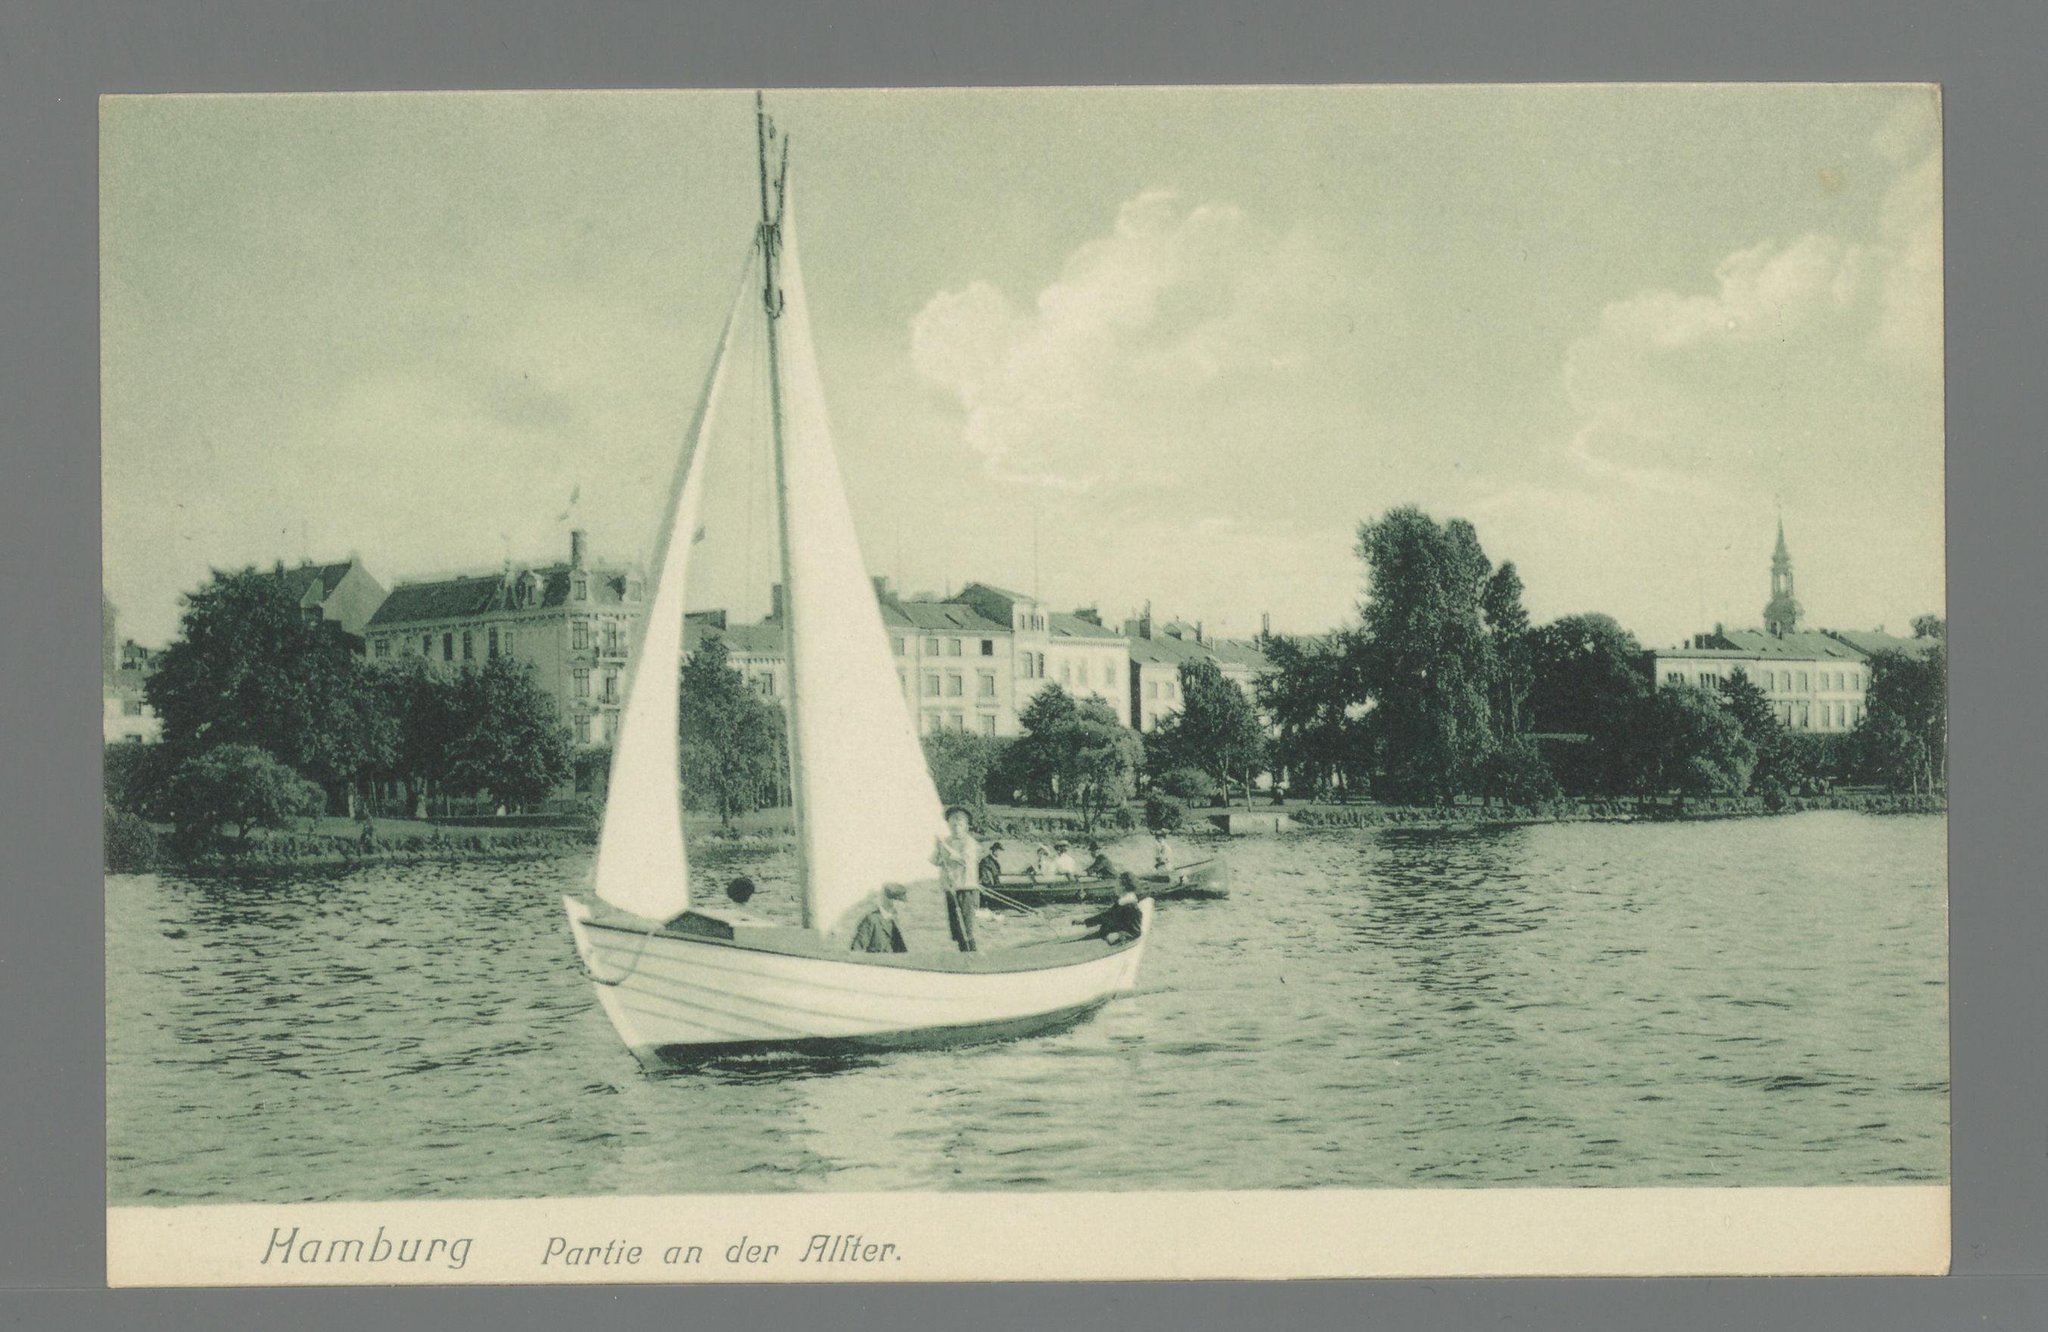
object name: photomechanical print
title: Luxusdruck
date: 1905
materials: cardboard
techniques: photograph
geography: hamburg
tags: city-view, and landscape with man-made constructions, sailing-ship, sailing-boat, rowing-boat, canoe, etc., canals, waters (in city)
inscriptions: date